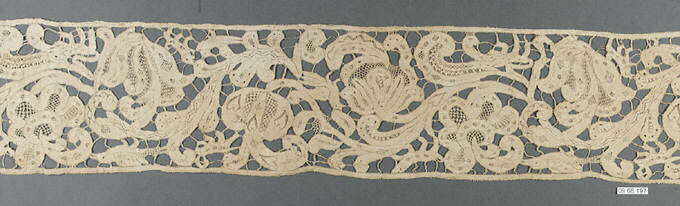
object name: strip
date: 1601-1700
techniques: lace